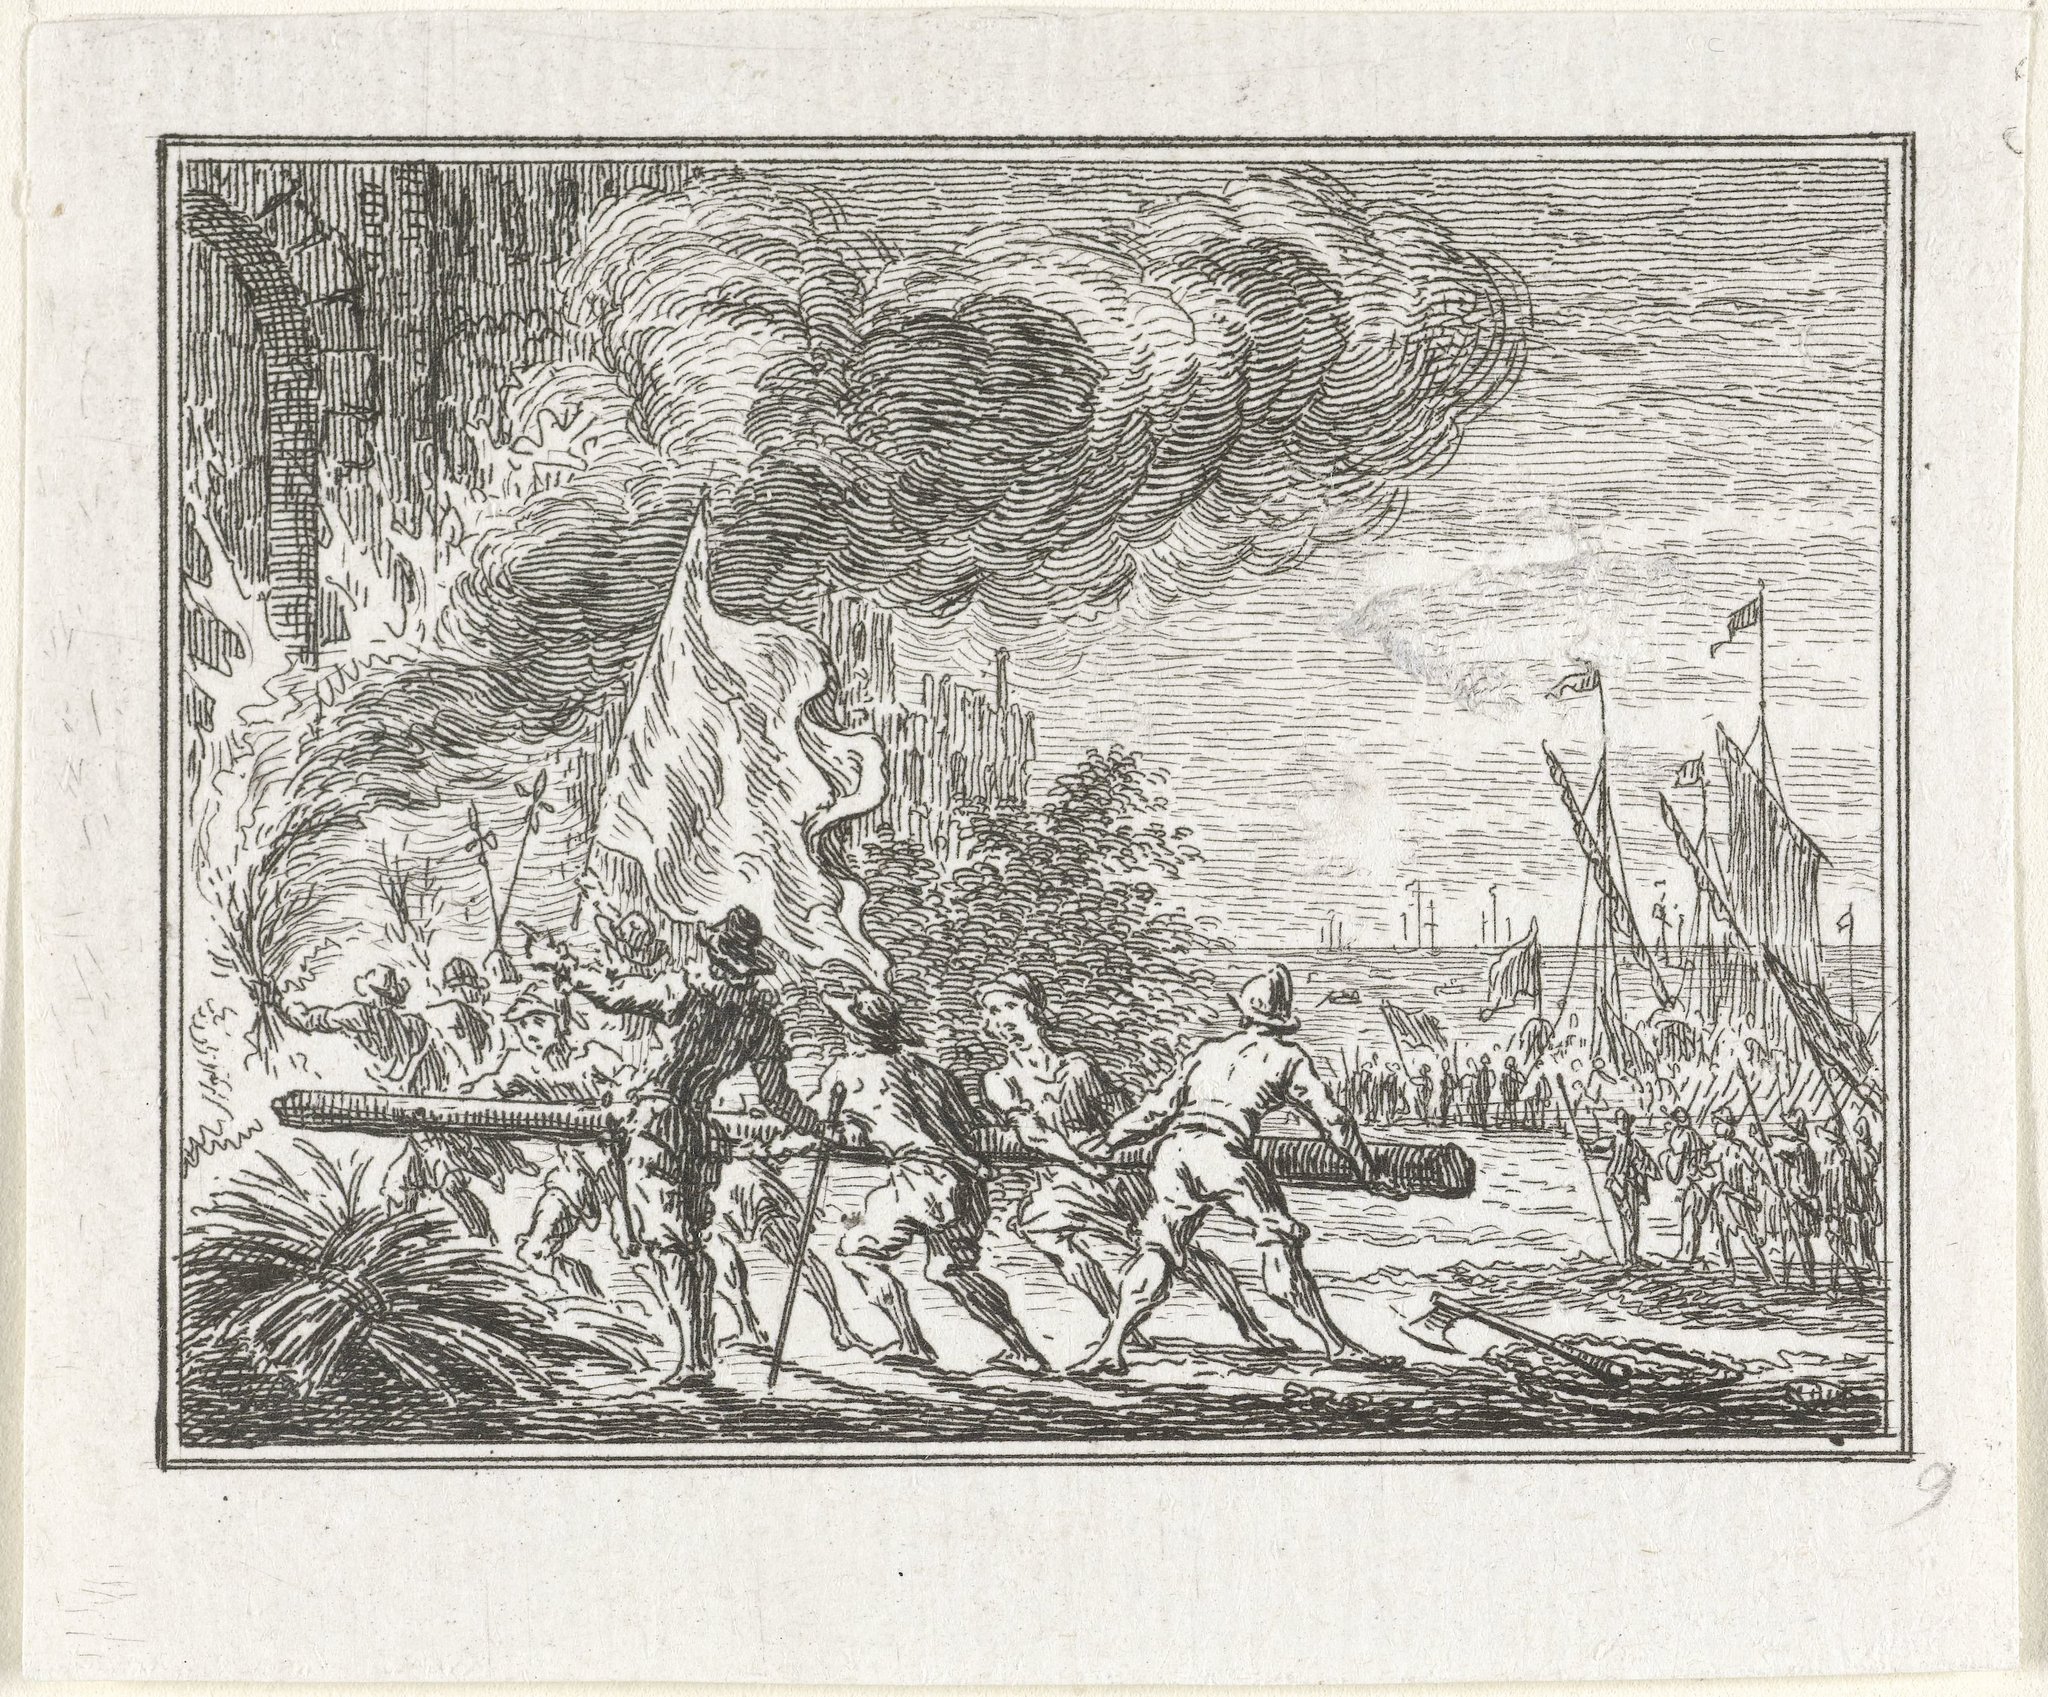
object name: print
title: Illustraties vaderlandse geschiedenis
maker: simon fokke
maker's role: draughtsman, print maker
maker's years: 1712-1784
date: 1752-1782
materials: paper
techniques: etching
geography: amsterdam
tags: capture of city (after the siege), brielle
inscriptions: collector's mark: Lugt 2228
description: Voorstelling uit de vaderlandse geschiedenis. Gezicht op de stadspoort van Brielle en het omliggende land tijdens de inname door de Watergeuzen. Op de achtergrond de zee met schepen.